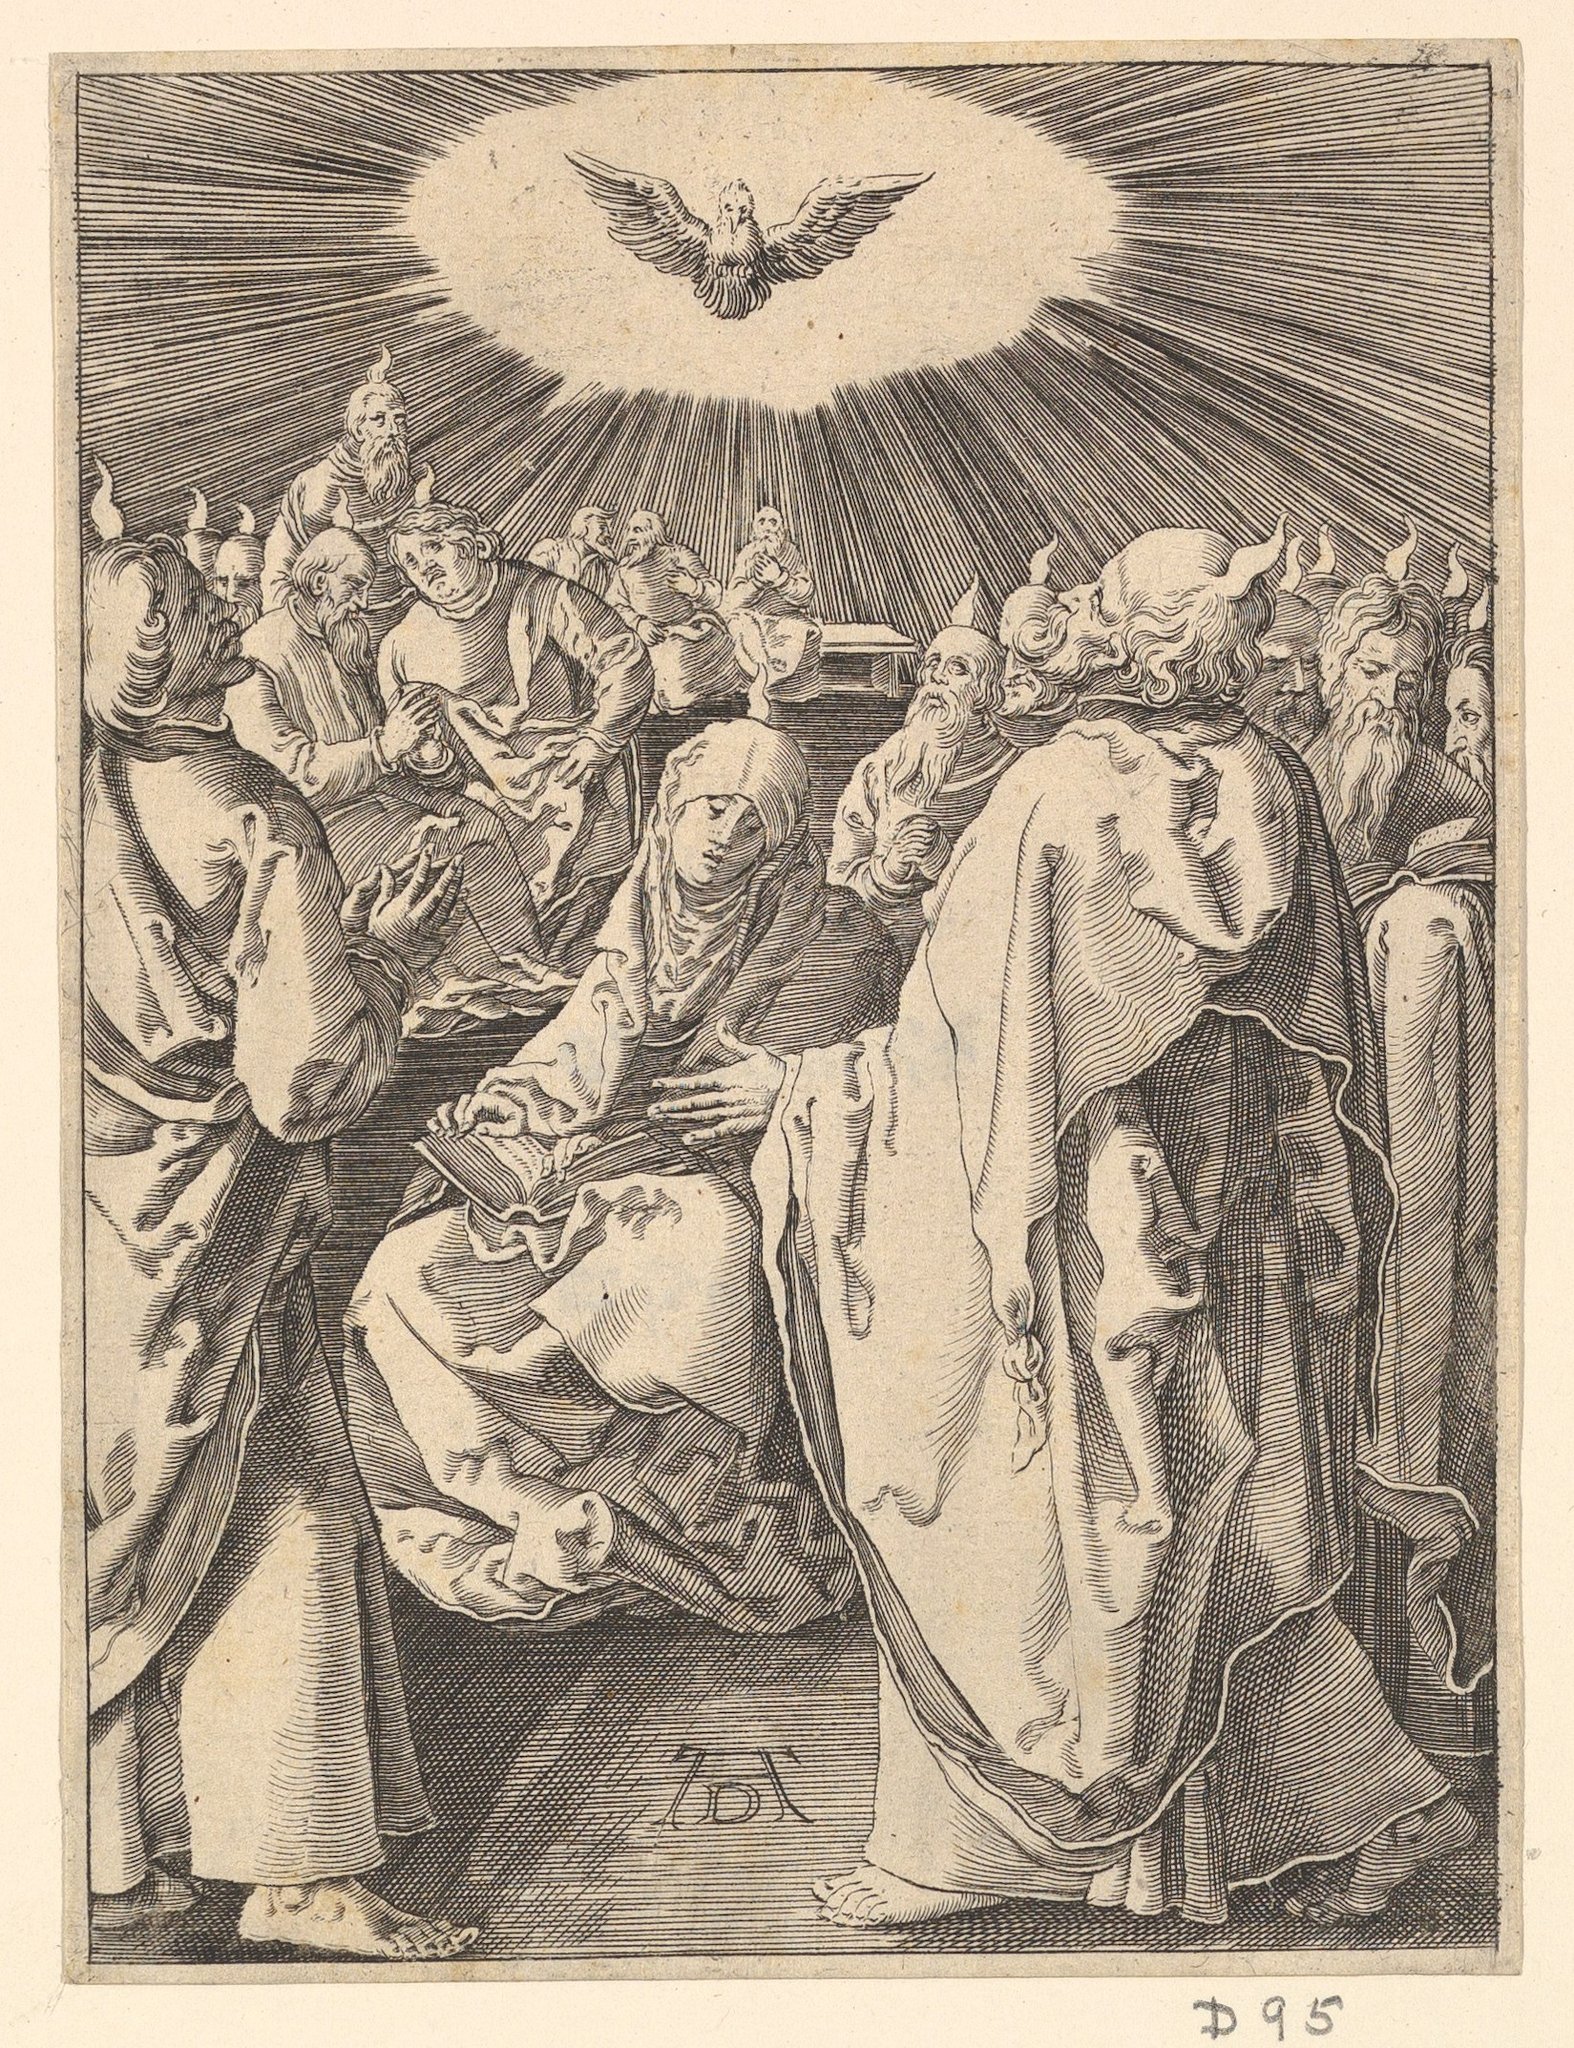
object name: print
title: Engraved copies of The Little Passion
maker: albrecht dürer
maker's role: artist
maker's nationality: german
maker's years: 1471-1528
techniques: engraving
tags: birds,men,virgin mary